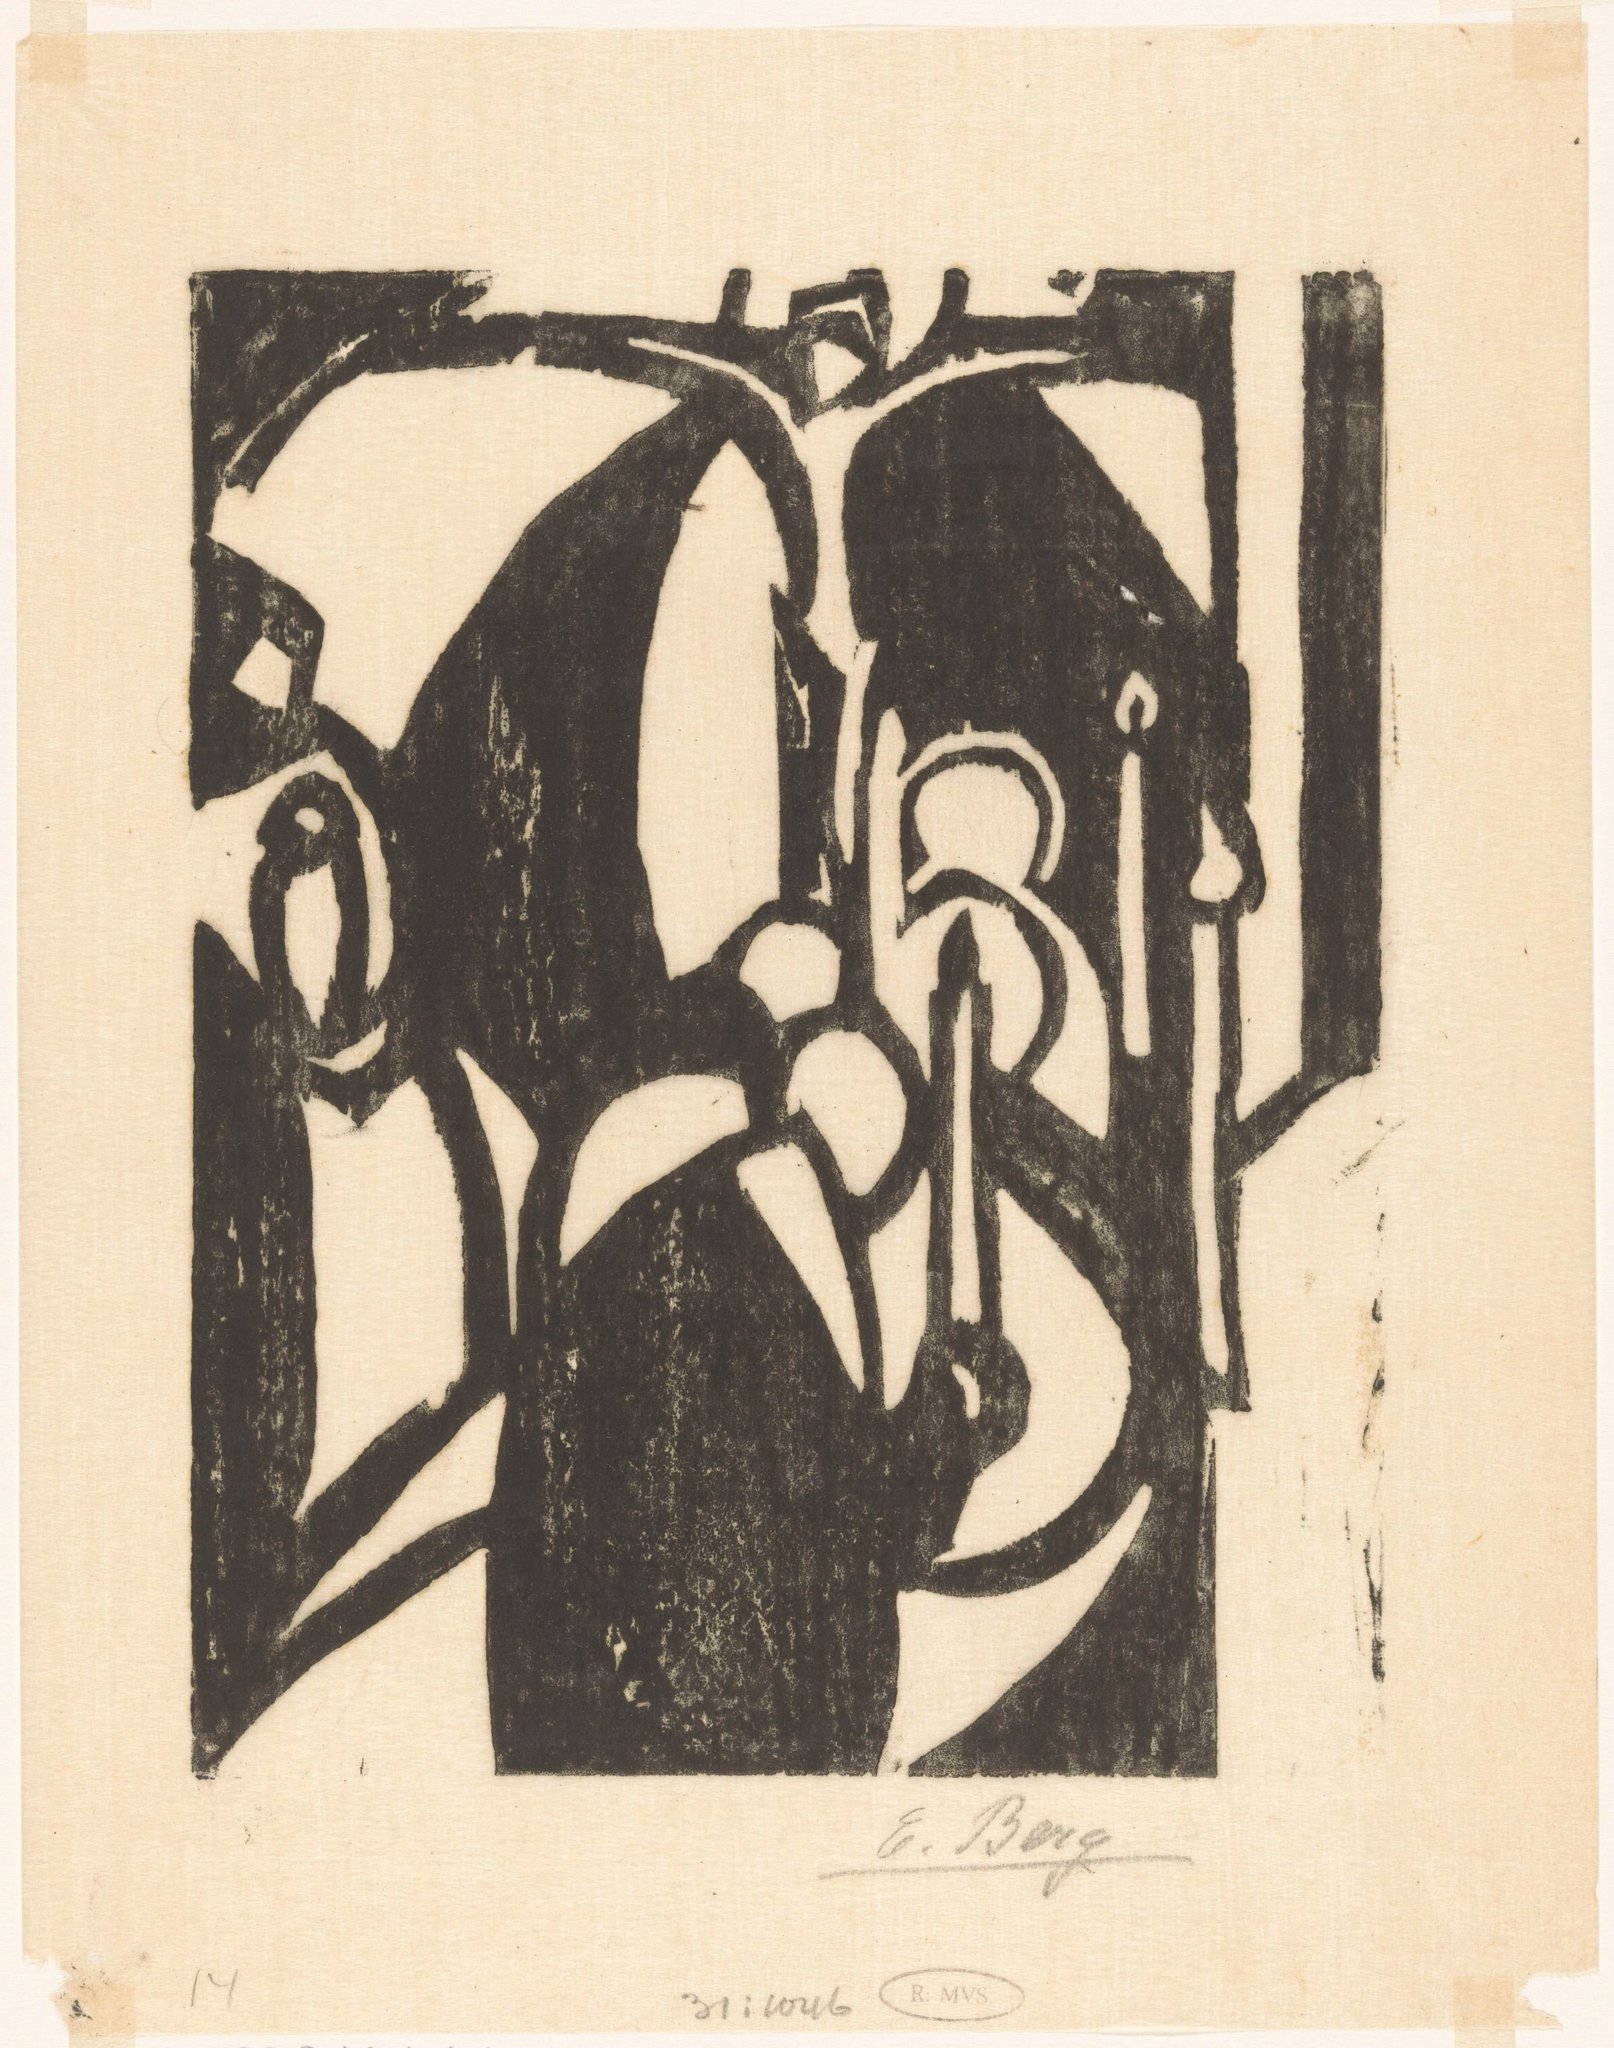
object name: print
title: Processie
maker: else berg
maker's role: designer, draughtsman, painter, print maker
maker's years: 1877-1942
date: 1915-1919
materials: paper, ink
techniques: woodcut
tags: procession ~ christian religion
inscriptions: number: ‘14’, collector's mark: Lugt 2228, signature: ‘E. Berg’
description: Mensen met kaarsen lopend naar rechts, naar een crucifix; gestileerd weergegeven.